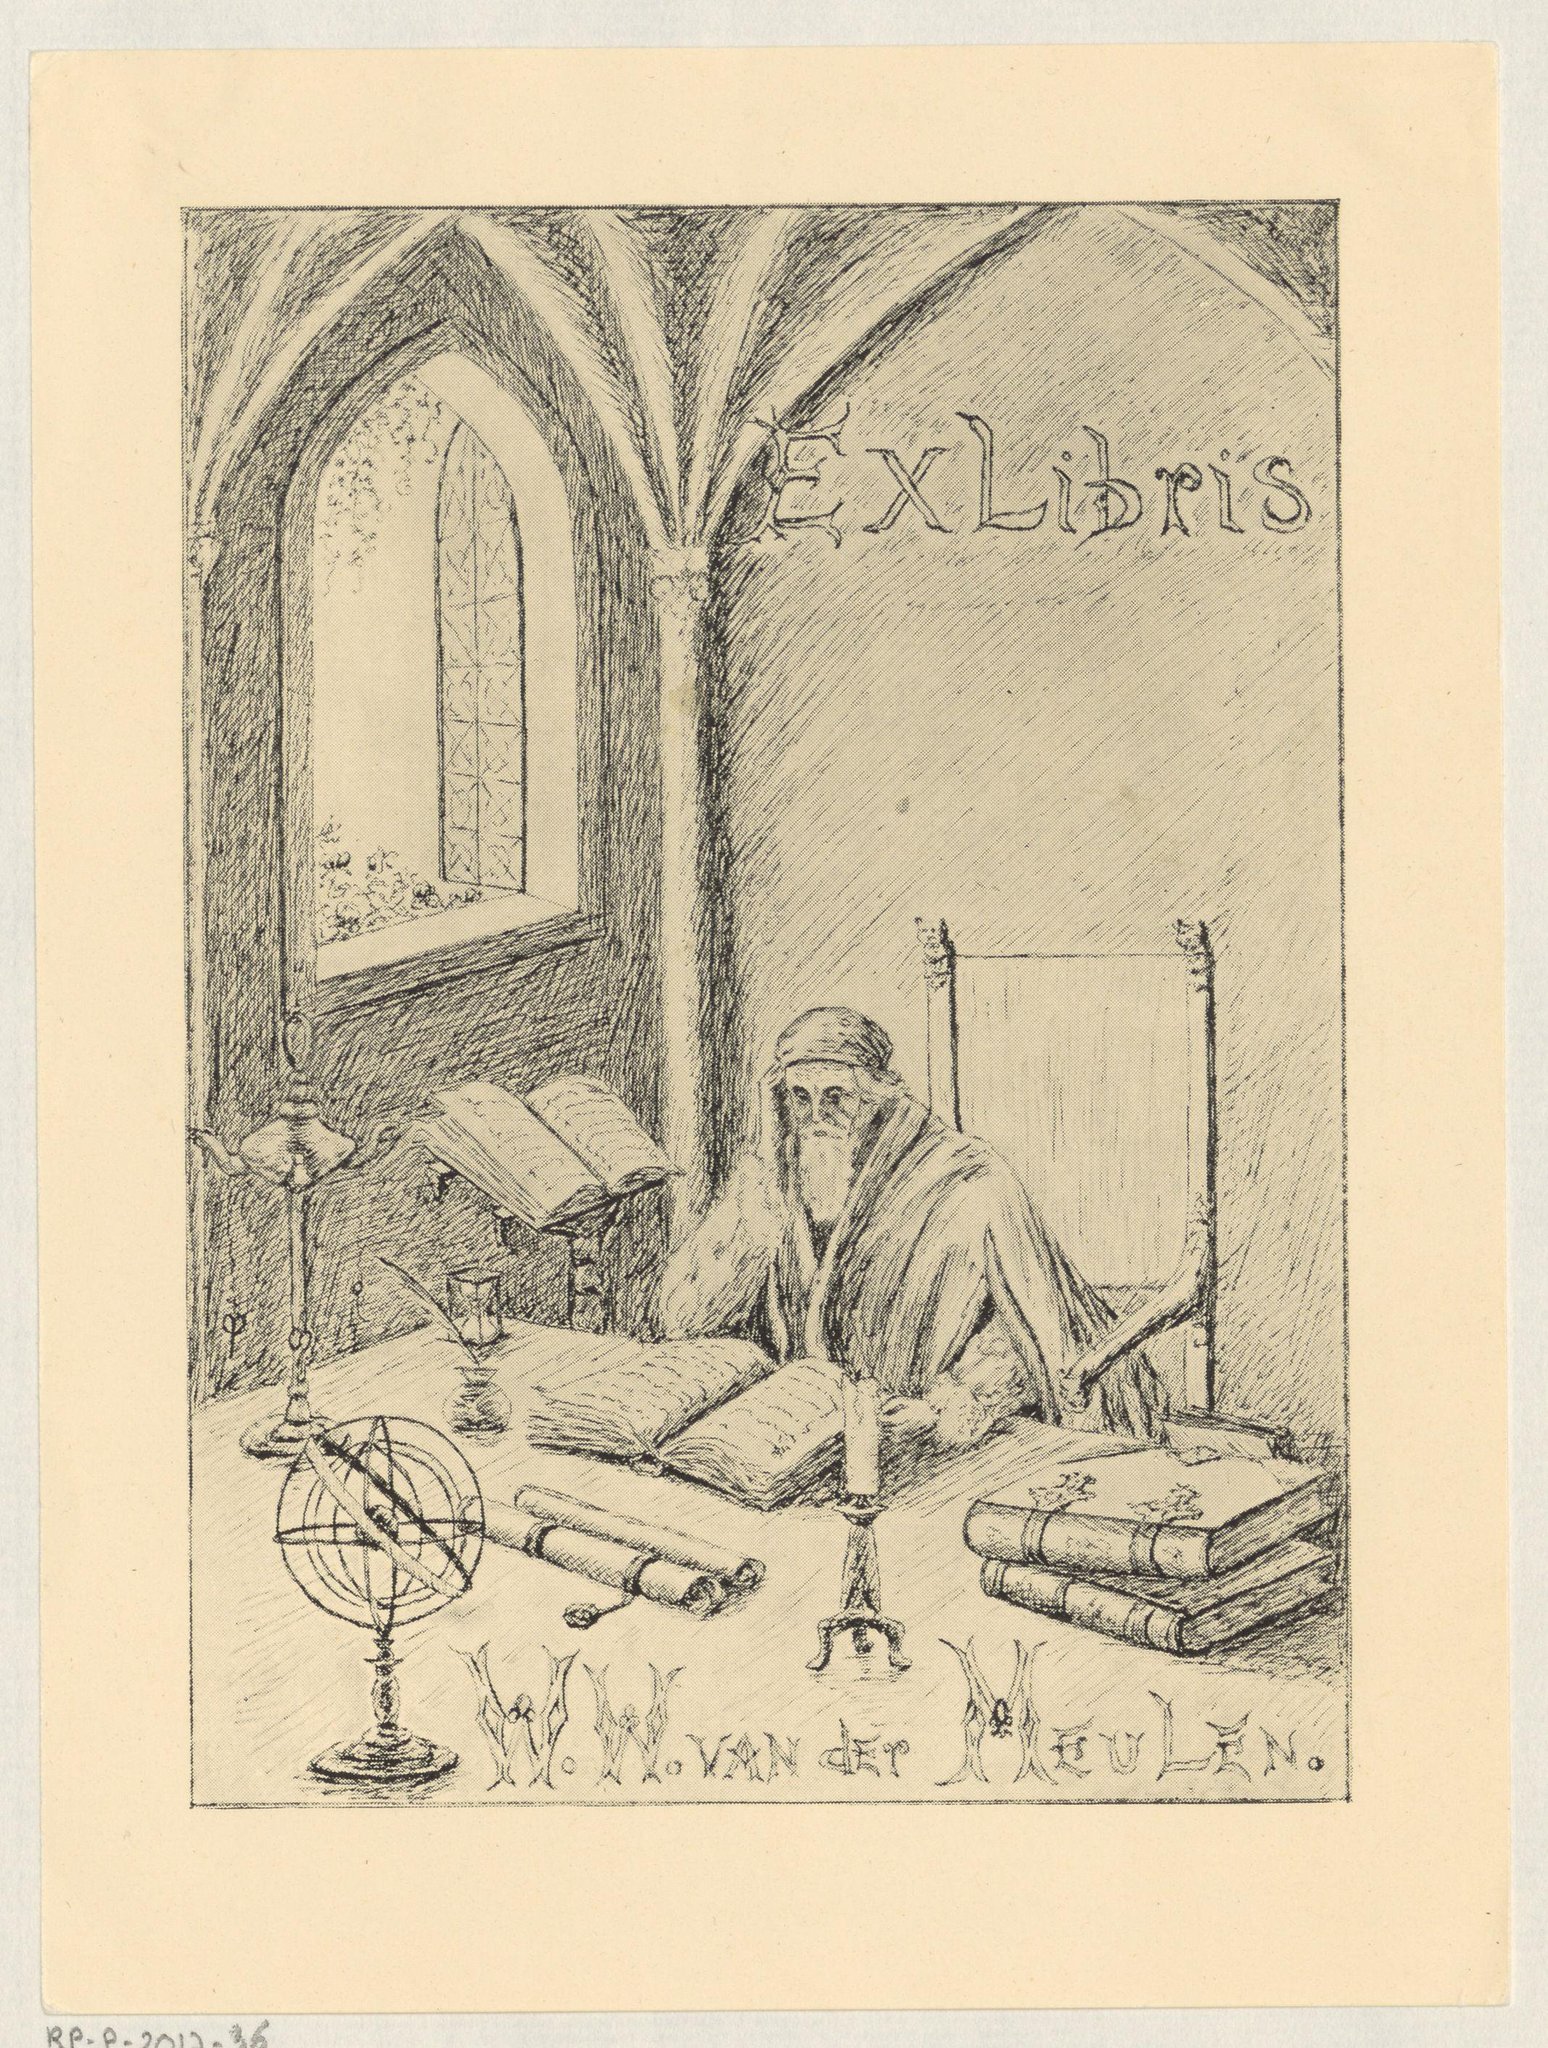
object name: bookplate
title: Ex libris van W.W. van der Meulen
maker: Anonymous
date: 1900-1999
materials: paper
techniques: autotype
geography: netherlands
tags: scholar in his study, old man, historical costume, book